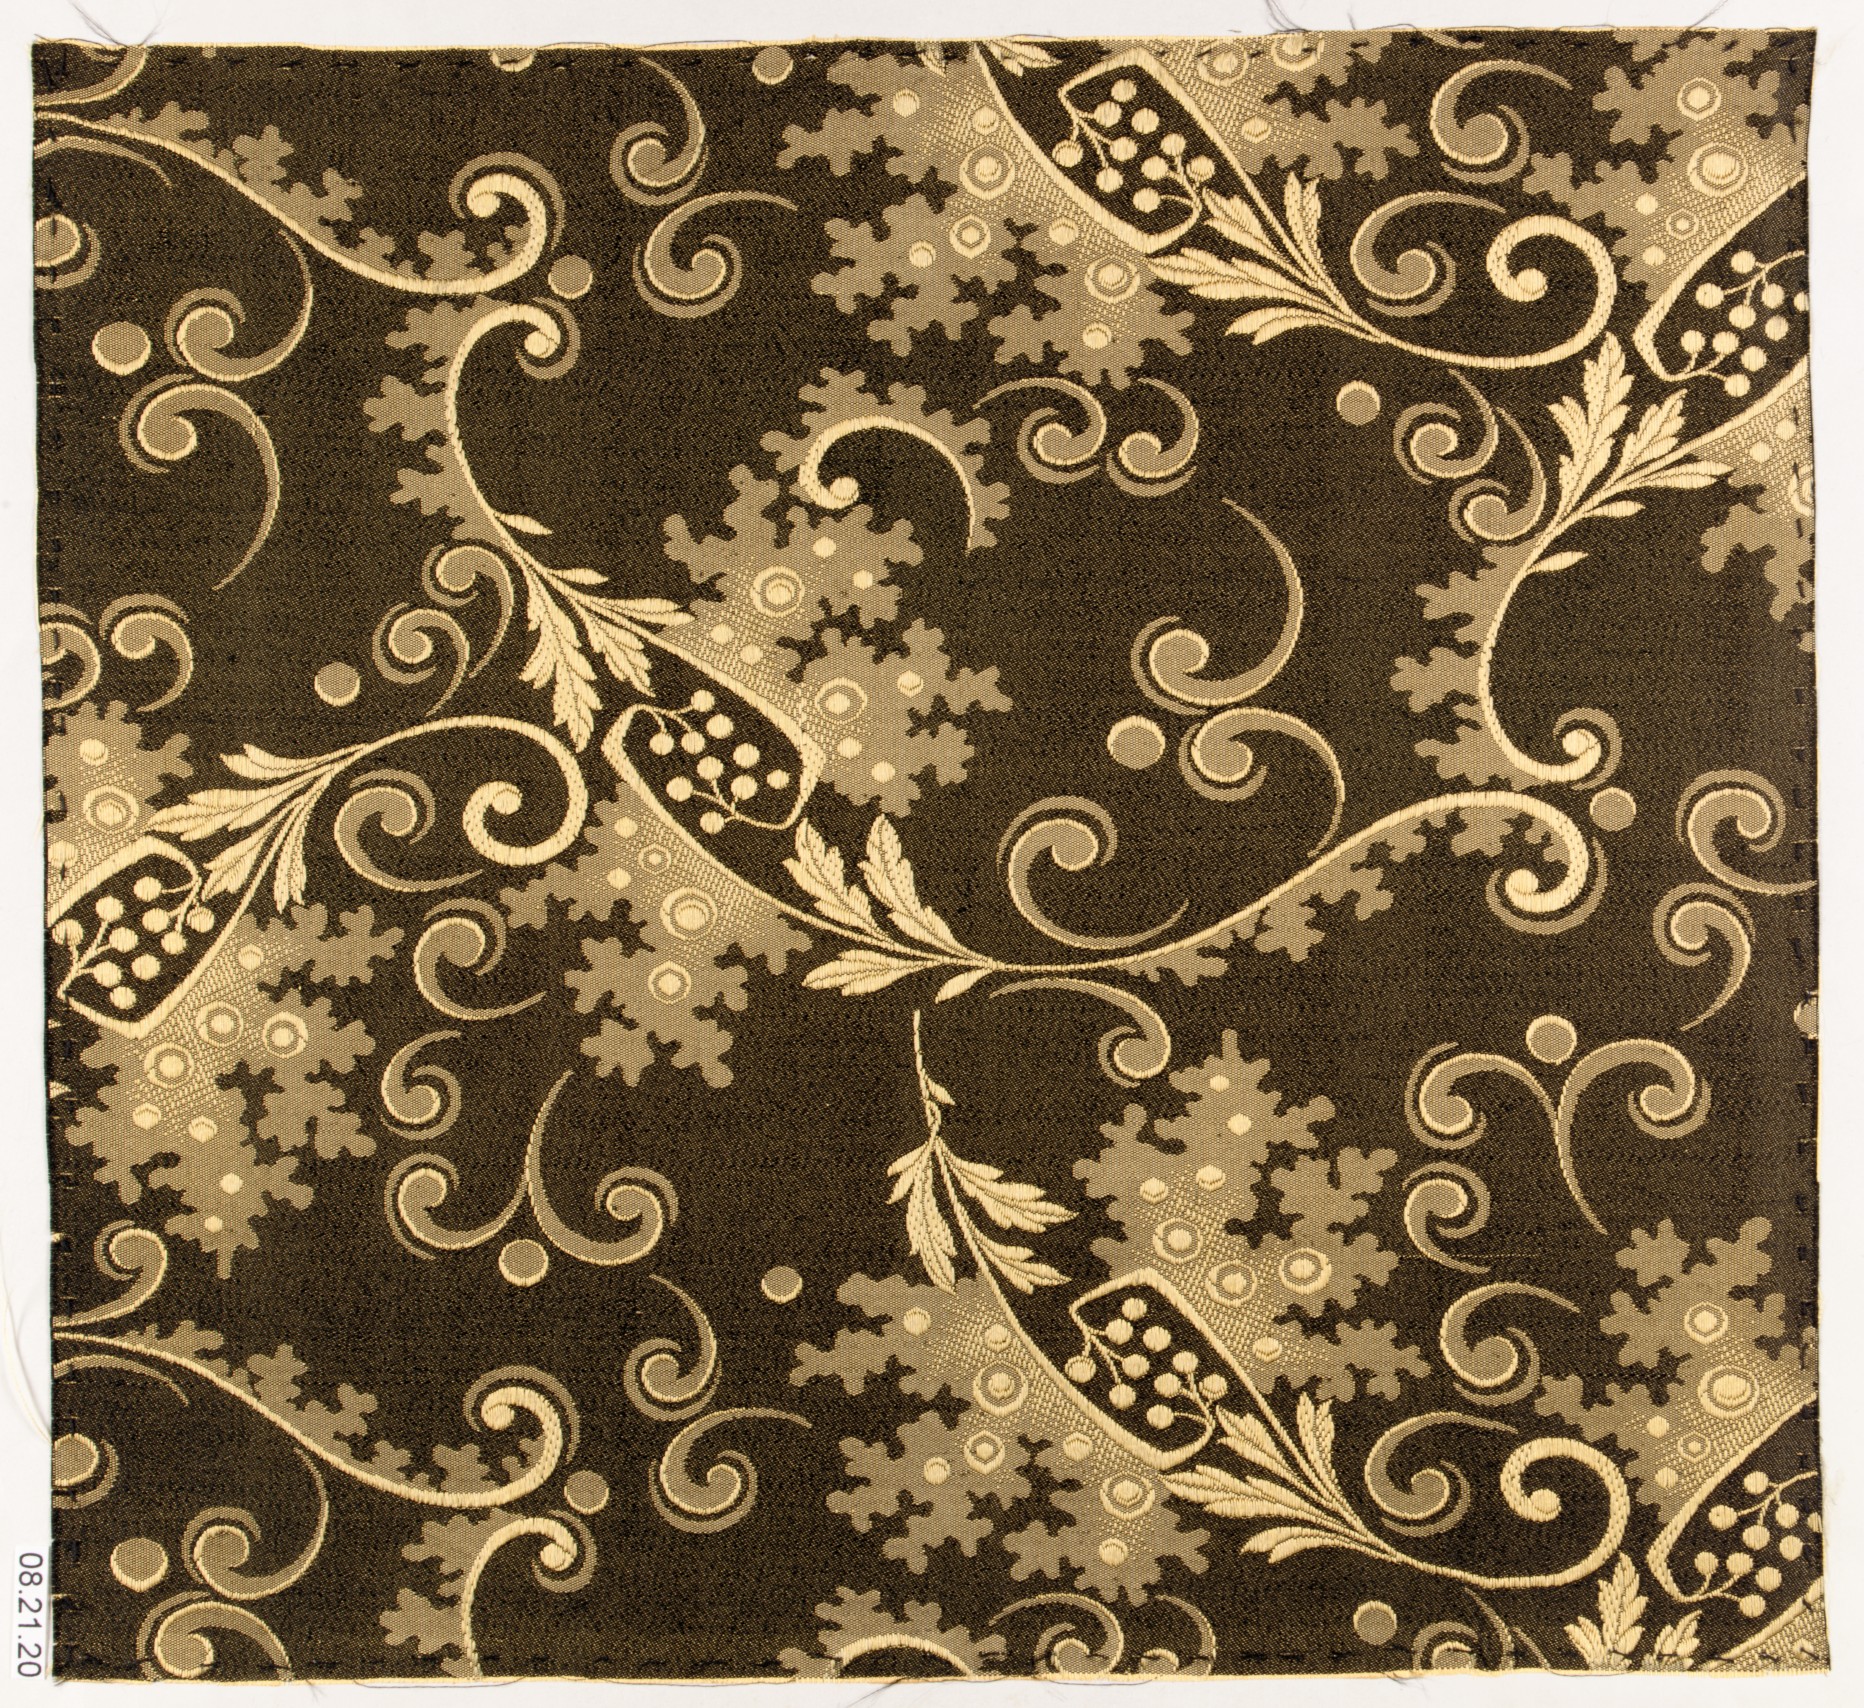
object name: textile sample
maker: Anonymous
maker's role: designer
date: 1900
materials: silk